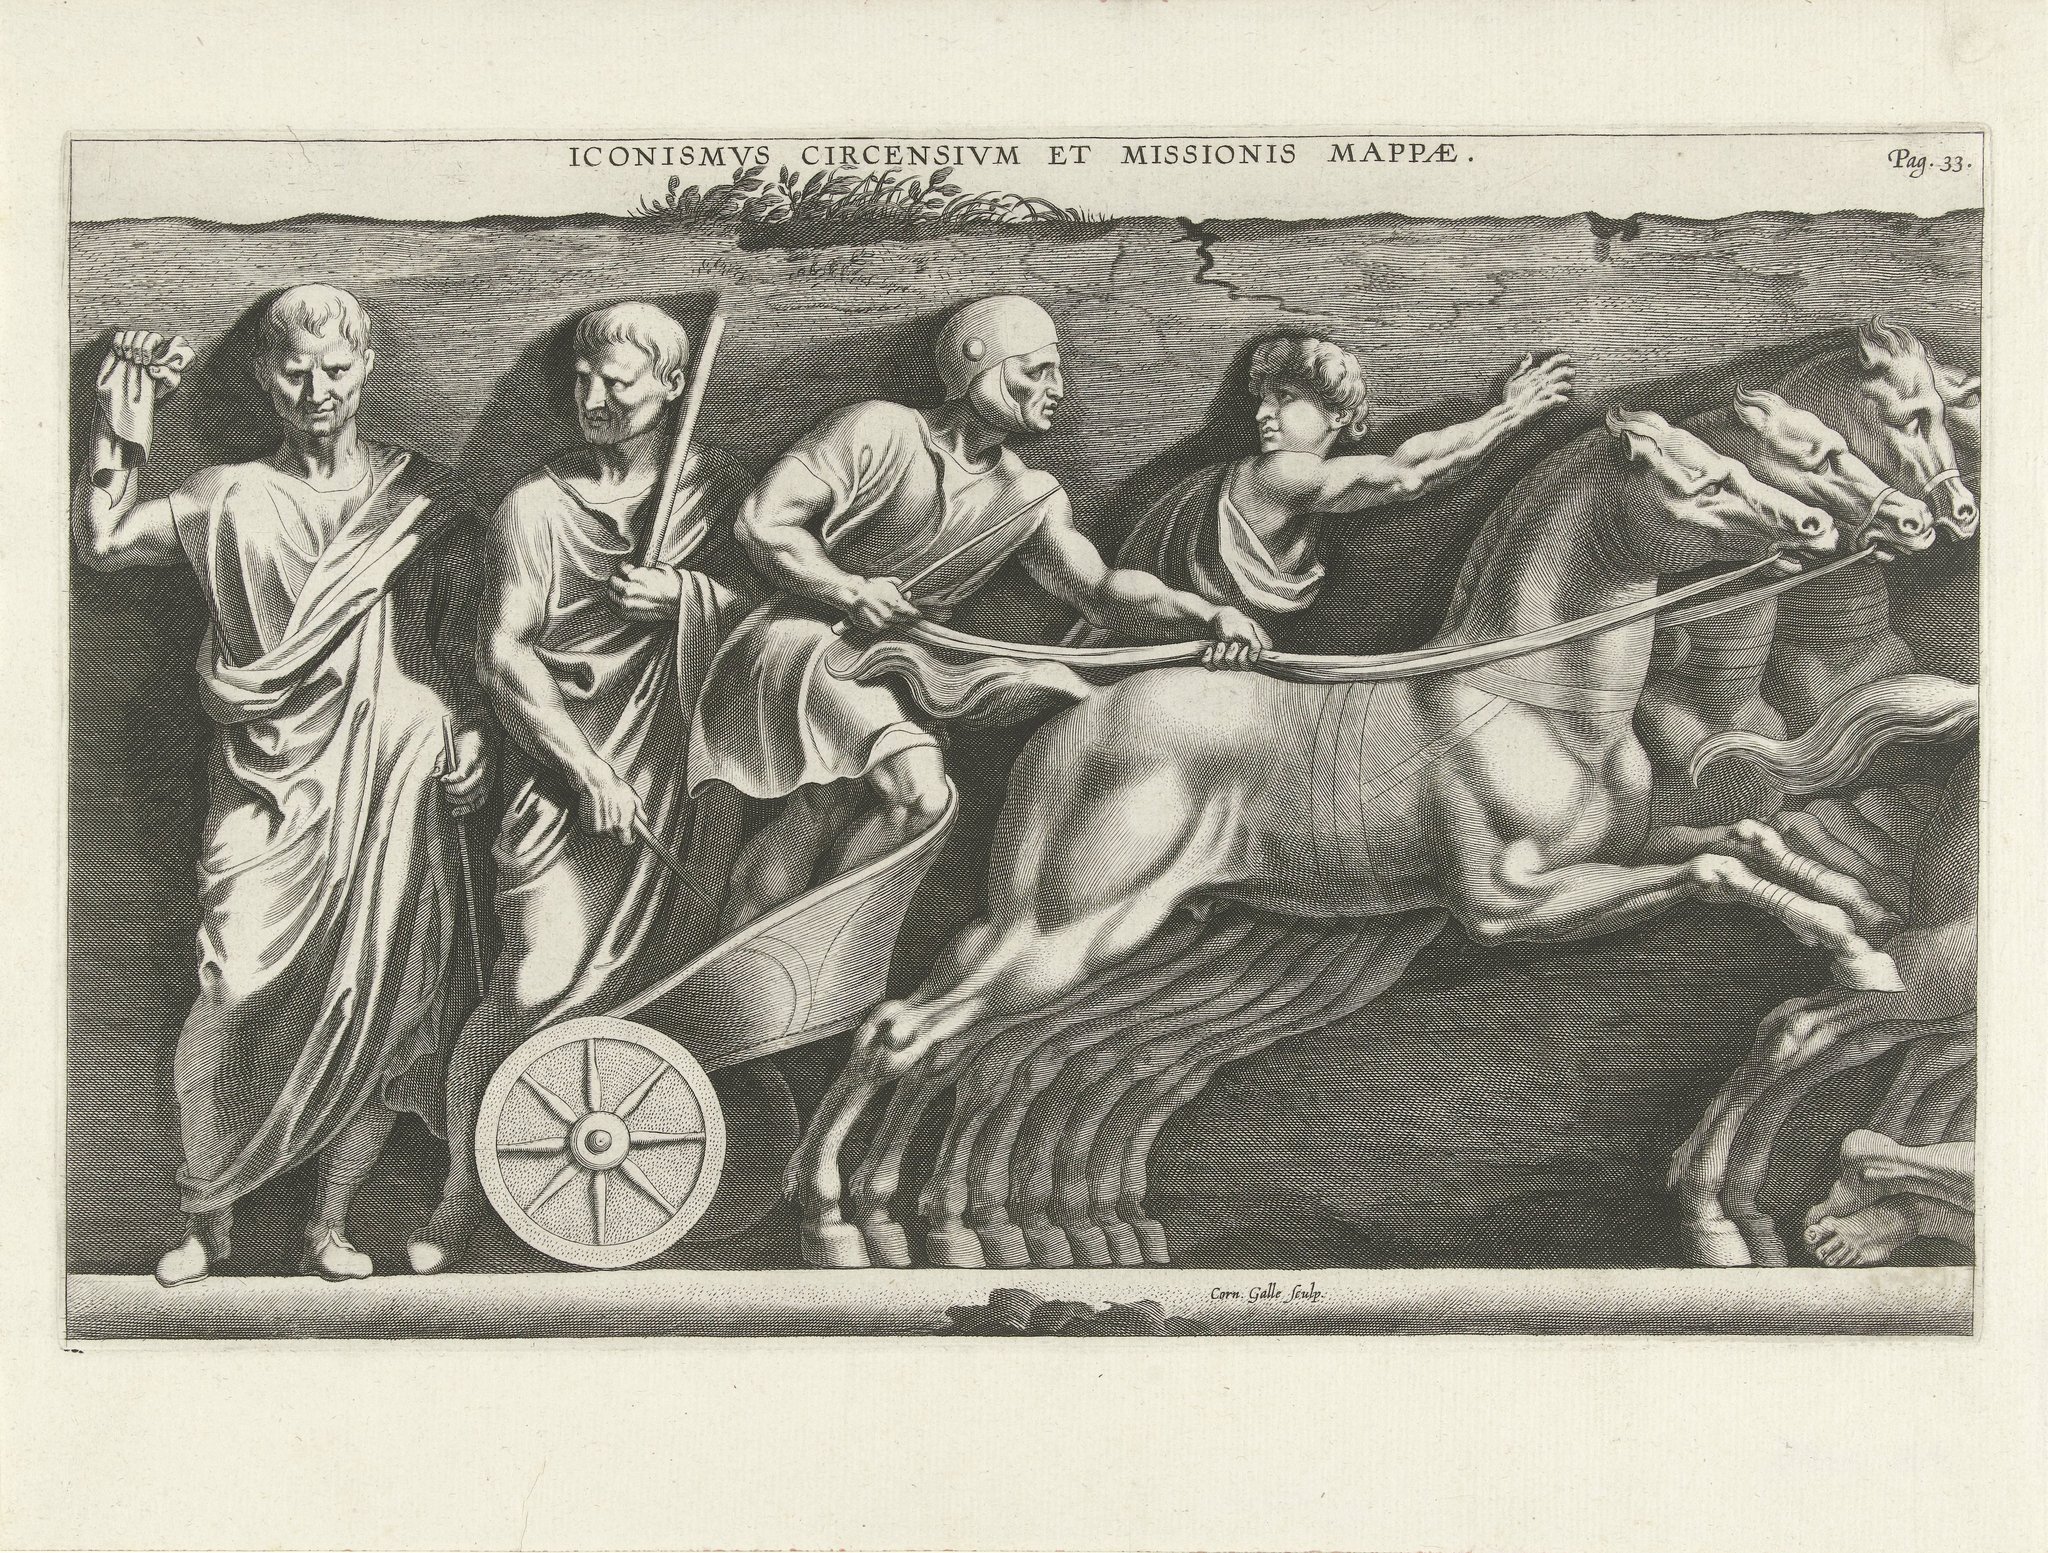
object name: print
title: Reliëf met man in wagen getrokken door paarden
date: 1608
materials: paper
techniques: engraving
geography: antwerp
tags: piece of sculpture, reproduction of a piece of sculpture, two-wheeled vehicle drawn by more than three animals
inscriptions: collector's mark: Lugt 240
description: Reliëf met de start van een paardenwagen wedstrijd. Links staat de opzichter met een doek in zijn hand, die het startsein geeft. De bestuurder van de wagen draagt een helm en houdt de teugels vast. Rechts de benen van een man die gevallen is. Illustratie voor een boek over Romeinse cultuur en gebruiken.